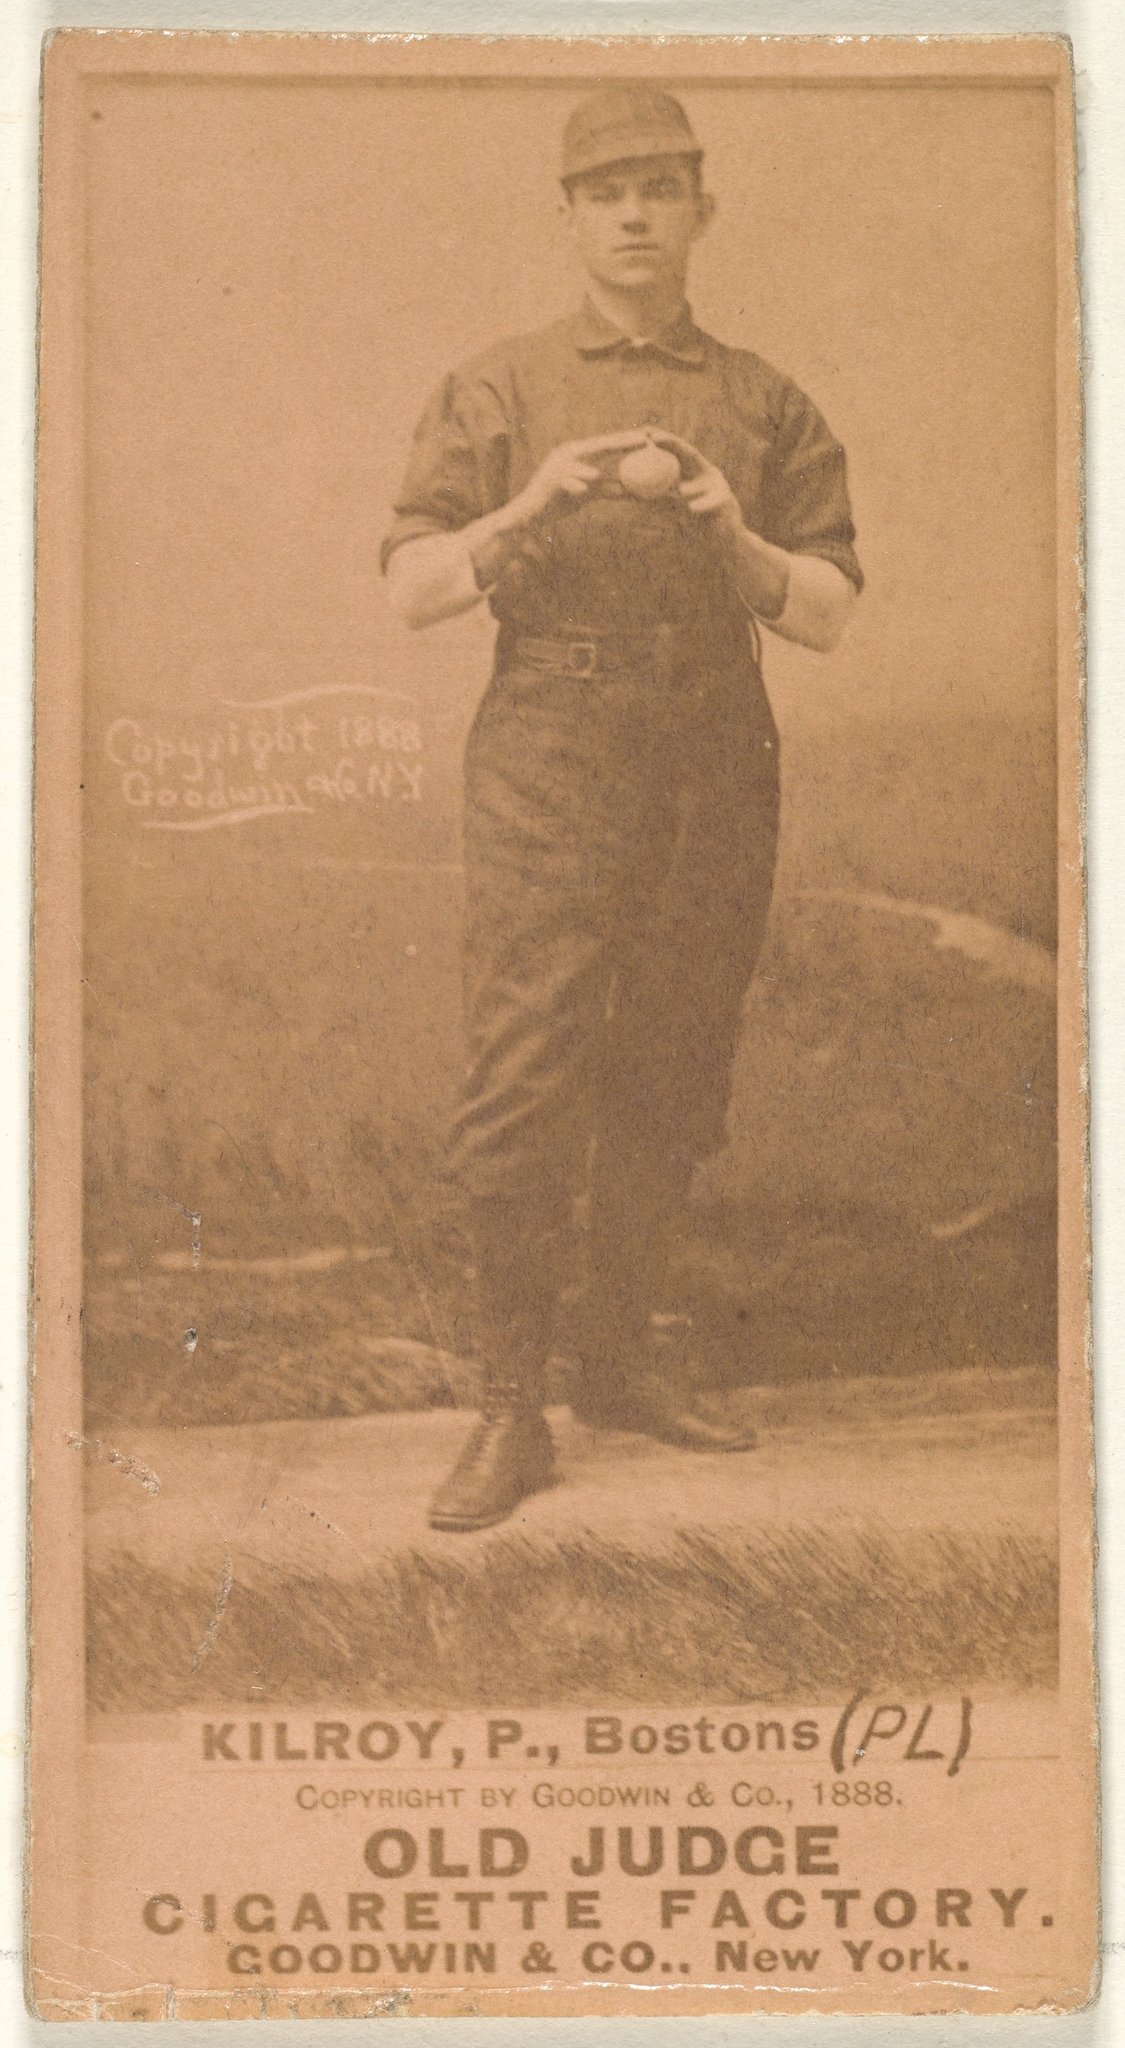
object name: baseball card, photograph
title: Kilroy, Pitcher, Boston, from the Old Judge series (N172) for Old Judge Cigarettes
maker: goodwin & company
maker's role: publisher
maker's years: 1850-1950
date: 1888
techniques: albumen silver print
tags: men,portraits,baseball,athletes